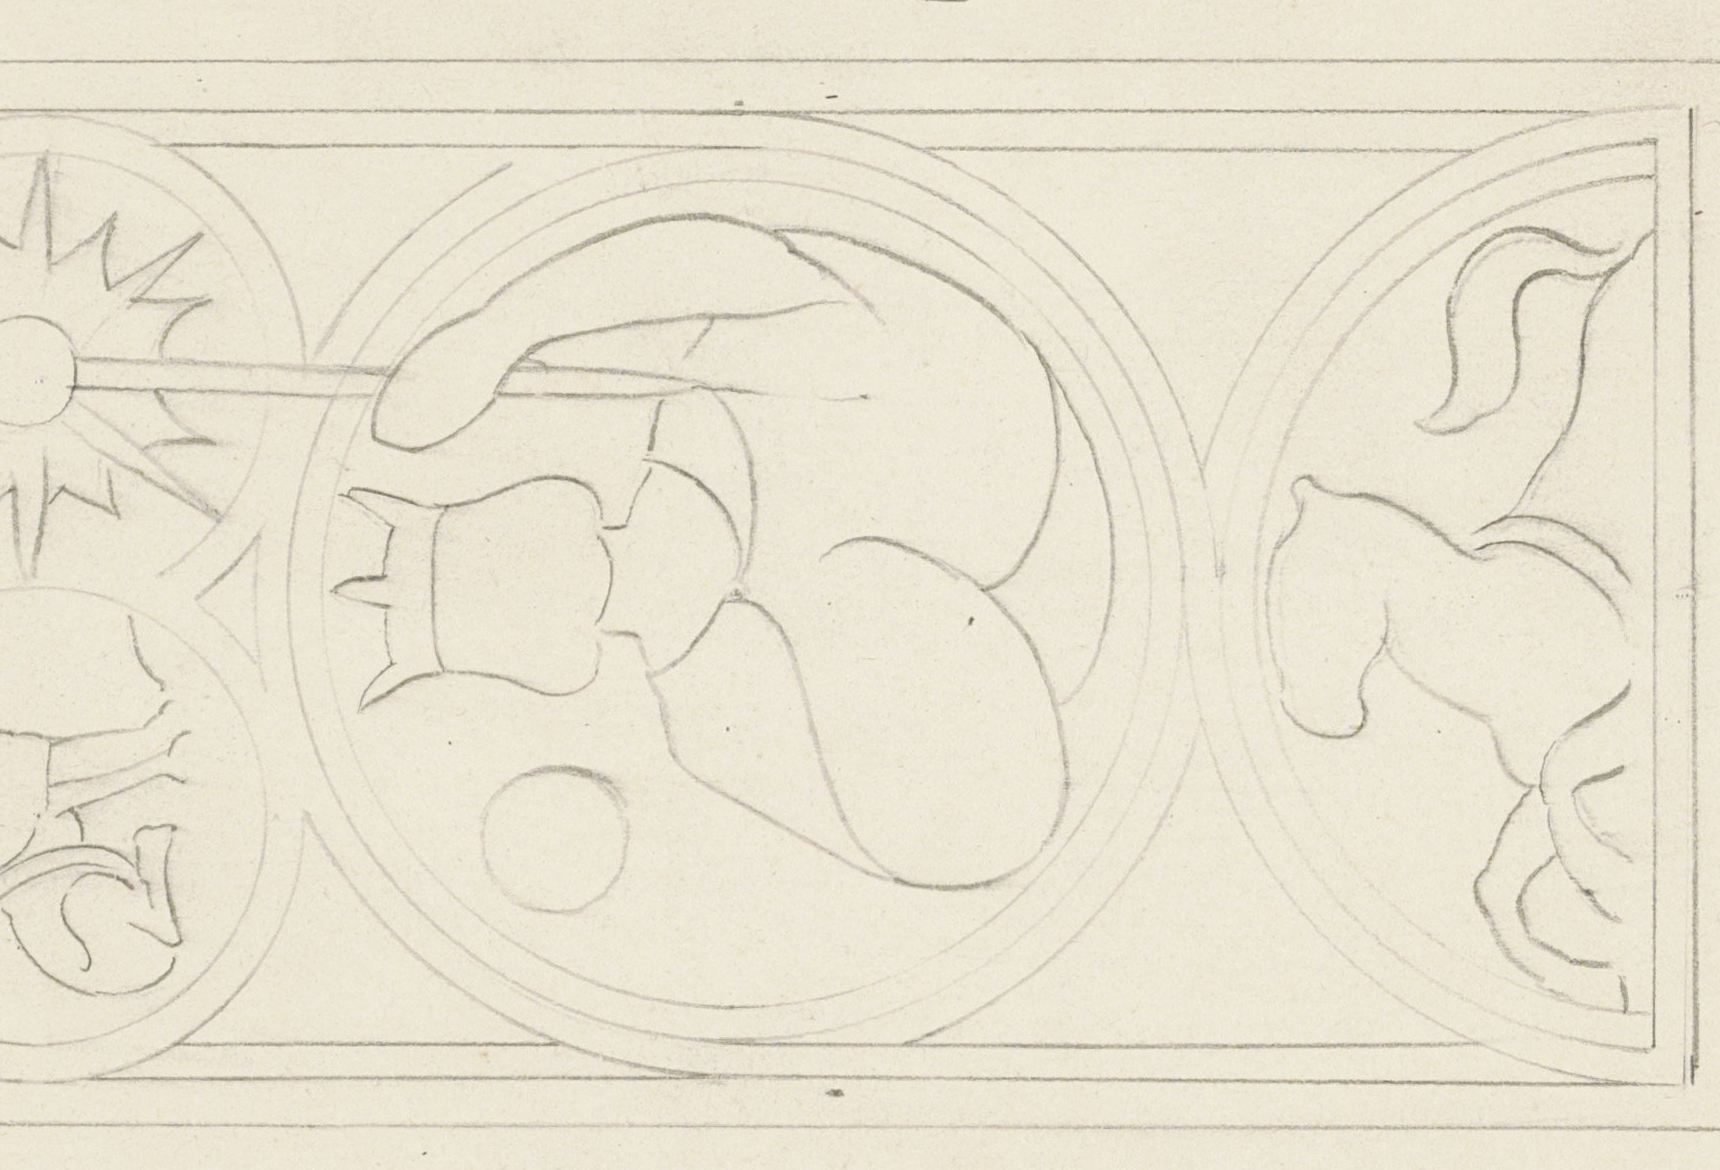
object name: sketchbook leaf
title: Zon van Gerechtigheid in een medaillon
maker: antoon derkinderen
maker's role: draughtsman, painter, print maker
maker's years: 1859-1925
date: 1900-1903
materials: paper, pencil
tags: libra (zodiacal sign of september), abstract ideas and concepts (+ personification)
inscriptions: annotation: ‘ma. 4.2.U-lieds daar & tegen - Sal de Sonne/ des Gerechtigheyt opgaan/ wegschaal/ [...]/ Eer/ Rijkdom/ [...]’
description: De Zon draagt een kroon en staf met zonnestralen. Boven het medaillon een kleiner medaillon met een voorstelling van het sterrenbeeld leeuw, eronder een half medaillon met een voorstelling van een paard. Ontwerp voor een glas-in-loodraam voor de Kamer van Koophandel in de Beurs van Berlage te Amsterdam. Blad 6 recto uit een schetsboek met 45 bladen.